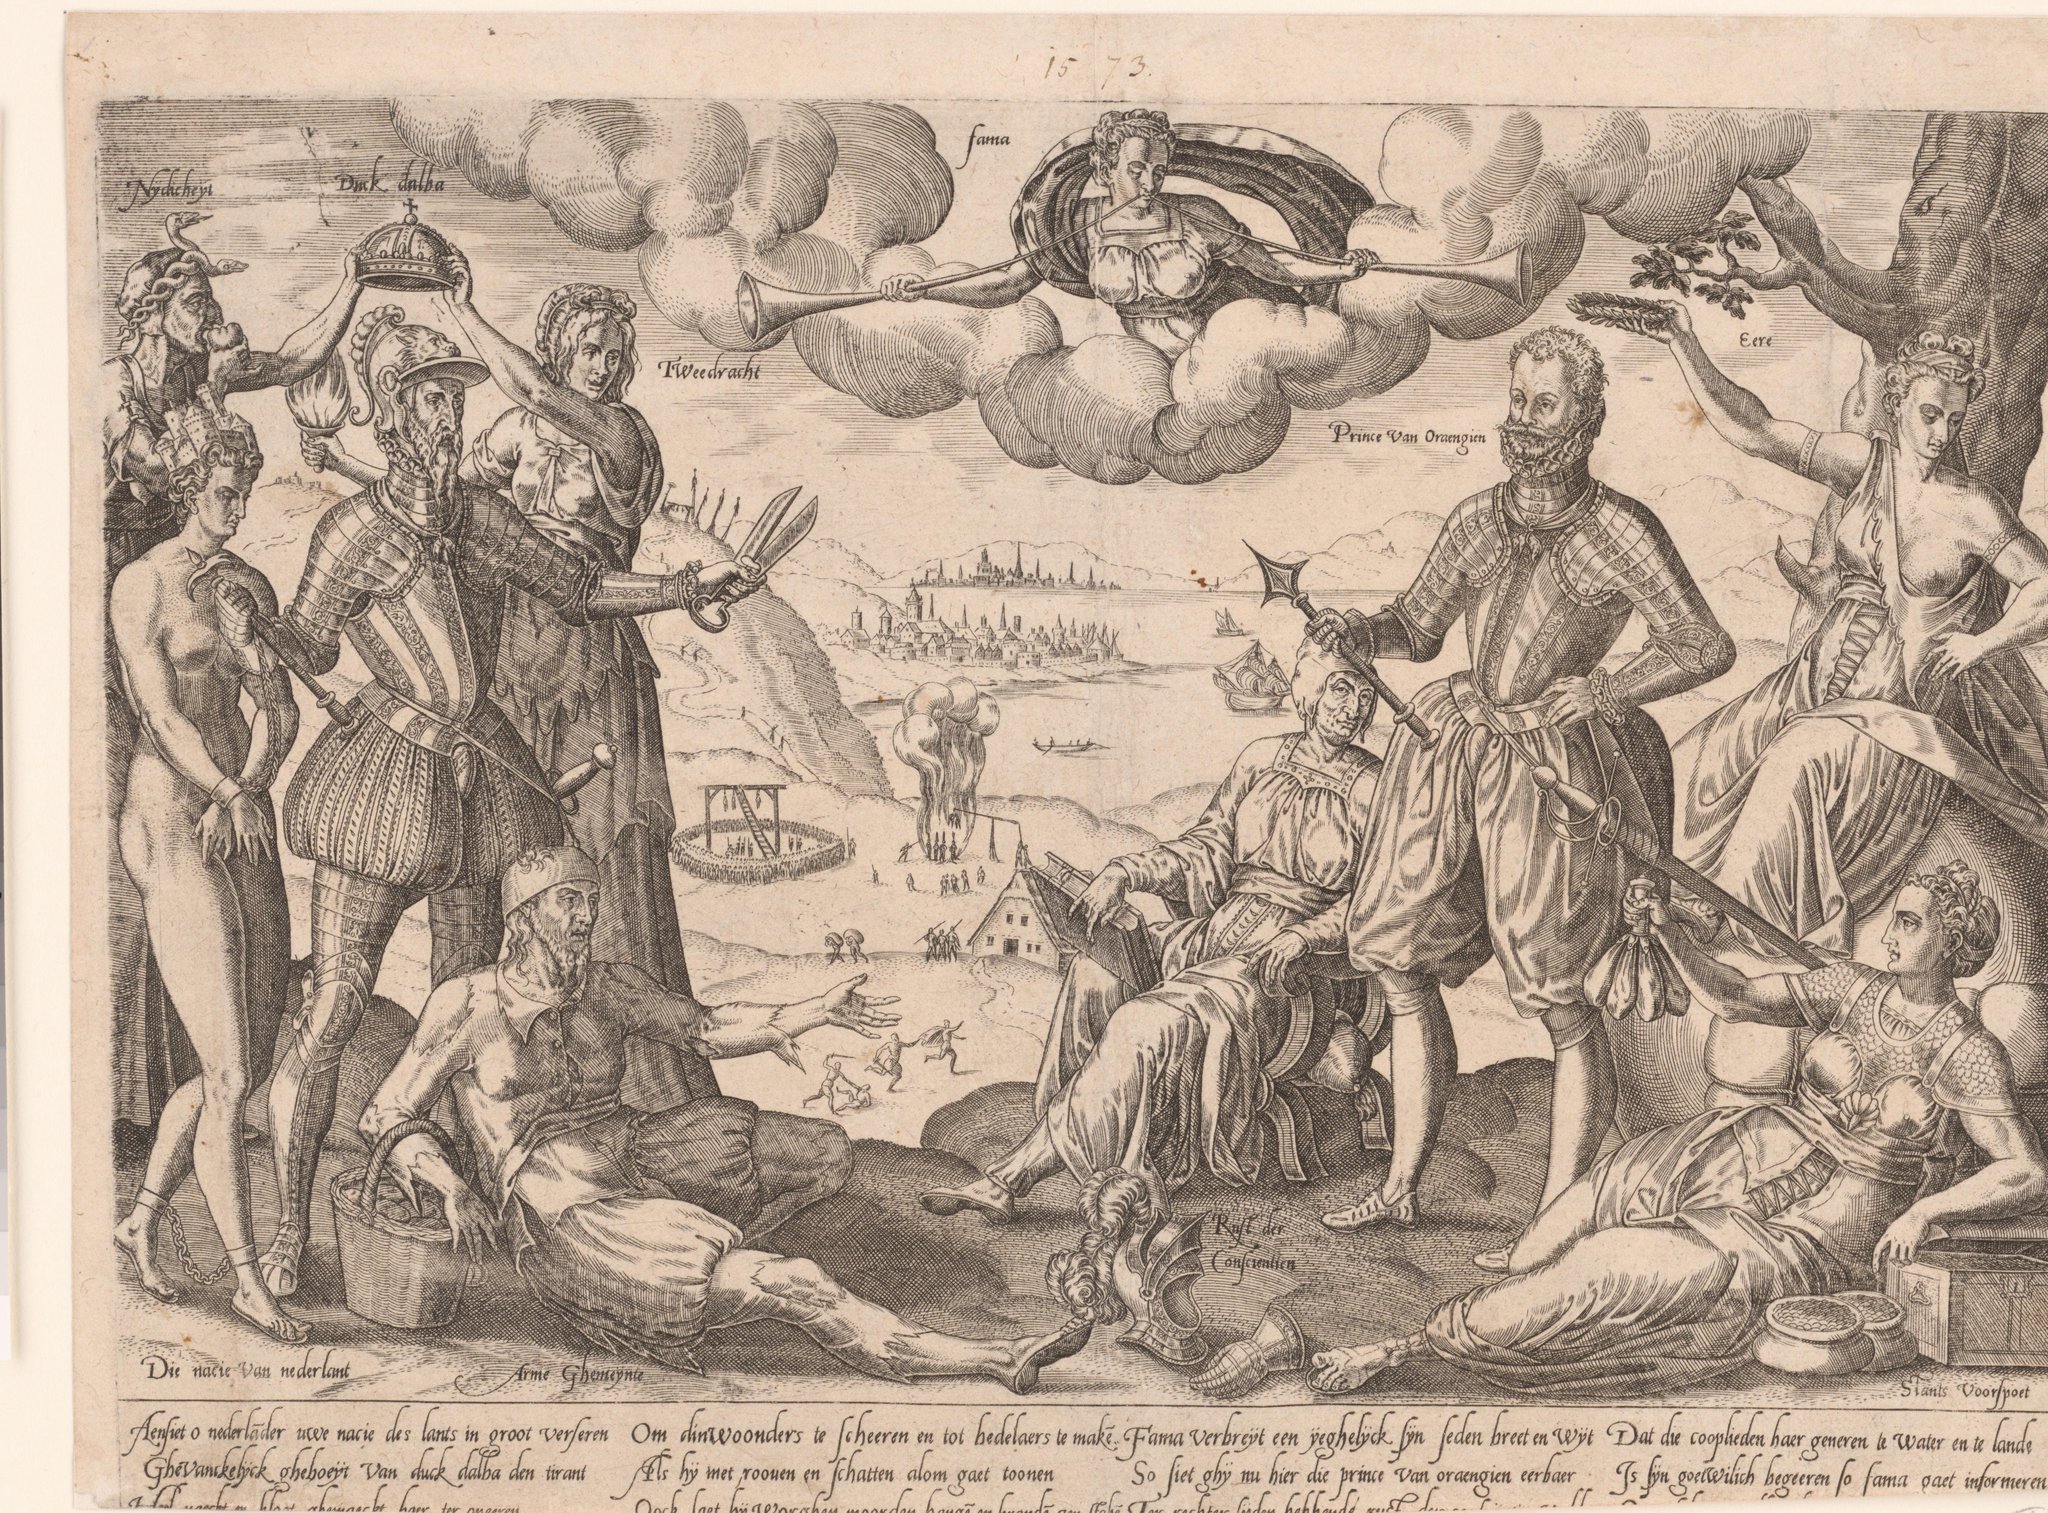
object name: propagandaprent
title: Allegorical Print of the Duke of Alva and the Prince of Orange, c. 1572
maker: Anonymous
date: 1568-1573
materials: paper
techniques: engraving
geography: low countries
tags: delft, william i (prince of orange), fernando álvarez de toledo (3rd duke of alba), counsel; 'consiglio' (ripa), envy; 'invidia' (ripa) ~ personification of one of the seven deadly sins, wealth, opulence; 'opulenza', 'richezza' (ripa), fame; 'fama', 'fama buona', 'fama chiara' (ripa), honour, glory; 'ampiezza della gloria', 'gloria', 'gloria de prencipi', 'gloria & honore', 'honore', 'sublimatà della gloria' (ripa), the poor, falsehood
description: The Duke of Alva and the Prince of Orange face each other. Alva is accompanied by Discord and Envy. He leads a nude woman in shackles, the Netherlands. Personified as a poor beggar, the people lie at his feet. William of Orange has other friends on his side: Honour, Wealth, and Clean Conscience. The message is clear: only he can restore peace and prosperity.